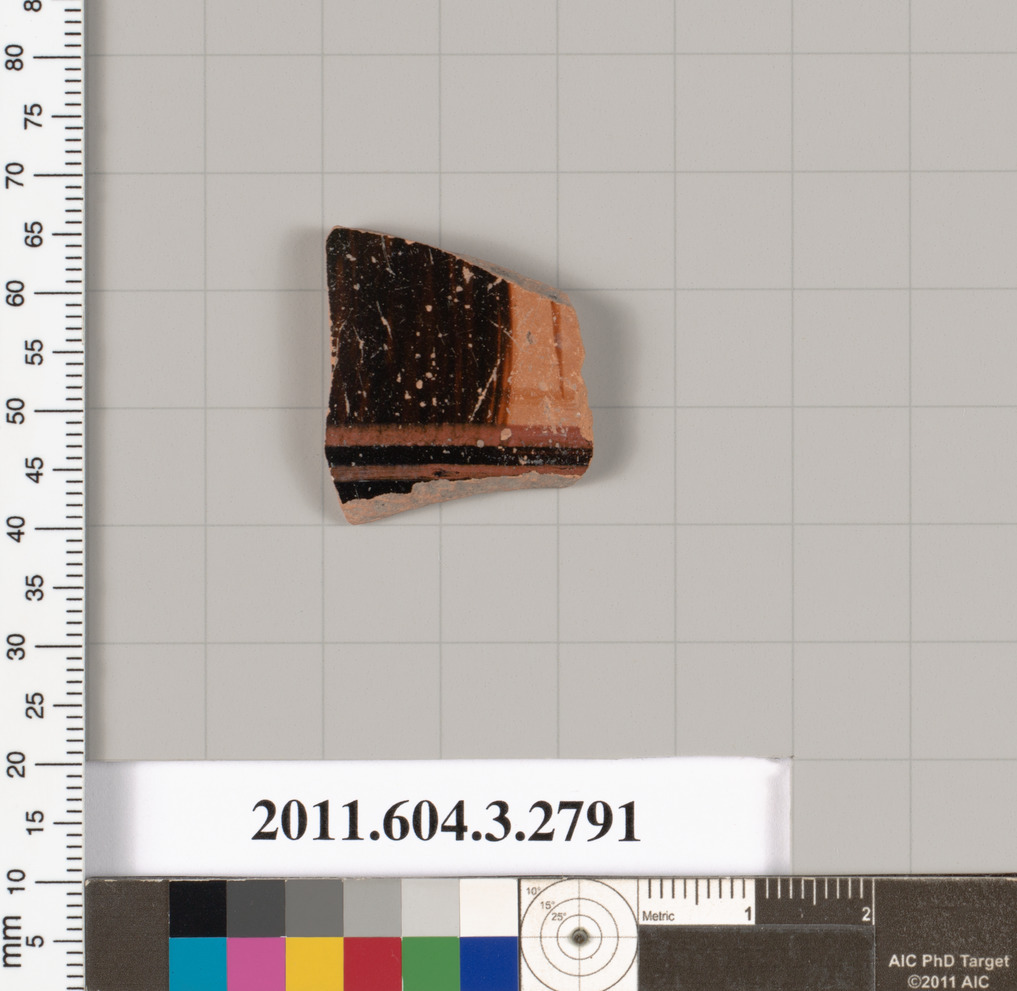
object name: oinochoe or olpe fragment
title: Terracotta fragment of an oinochoe (jug) or olpe (jug)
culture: greek, attic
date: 525-501 BCE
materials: terracotta